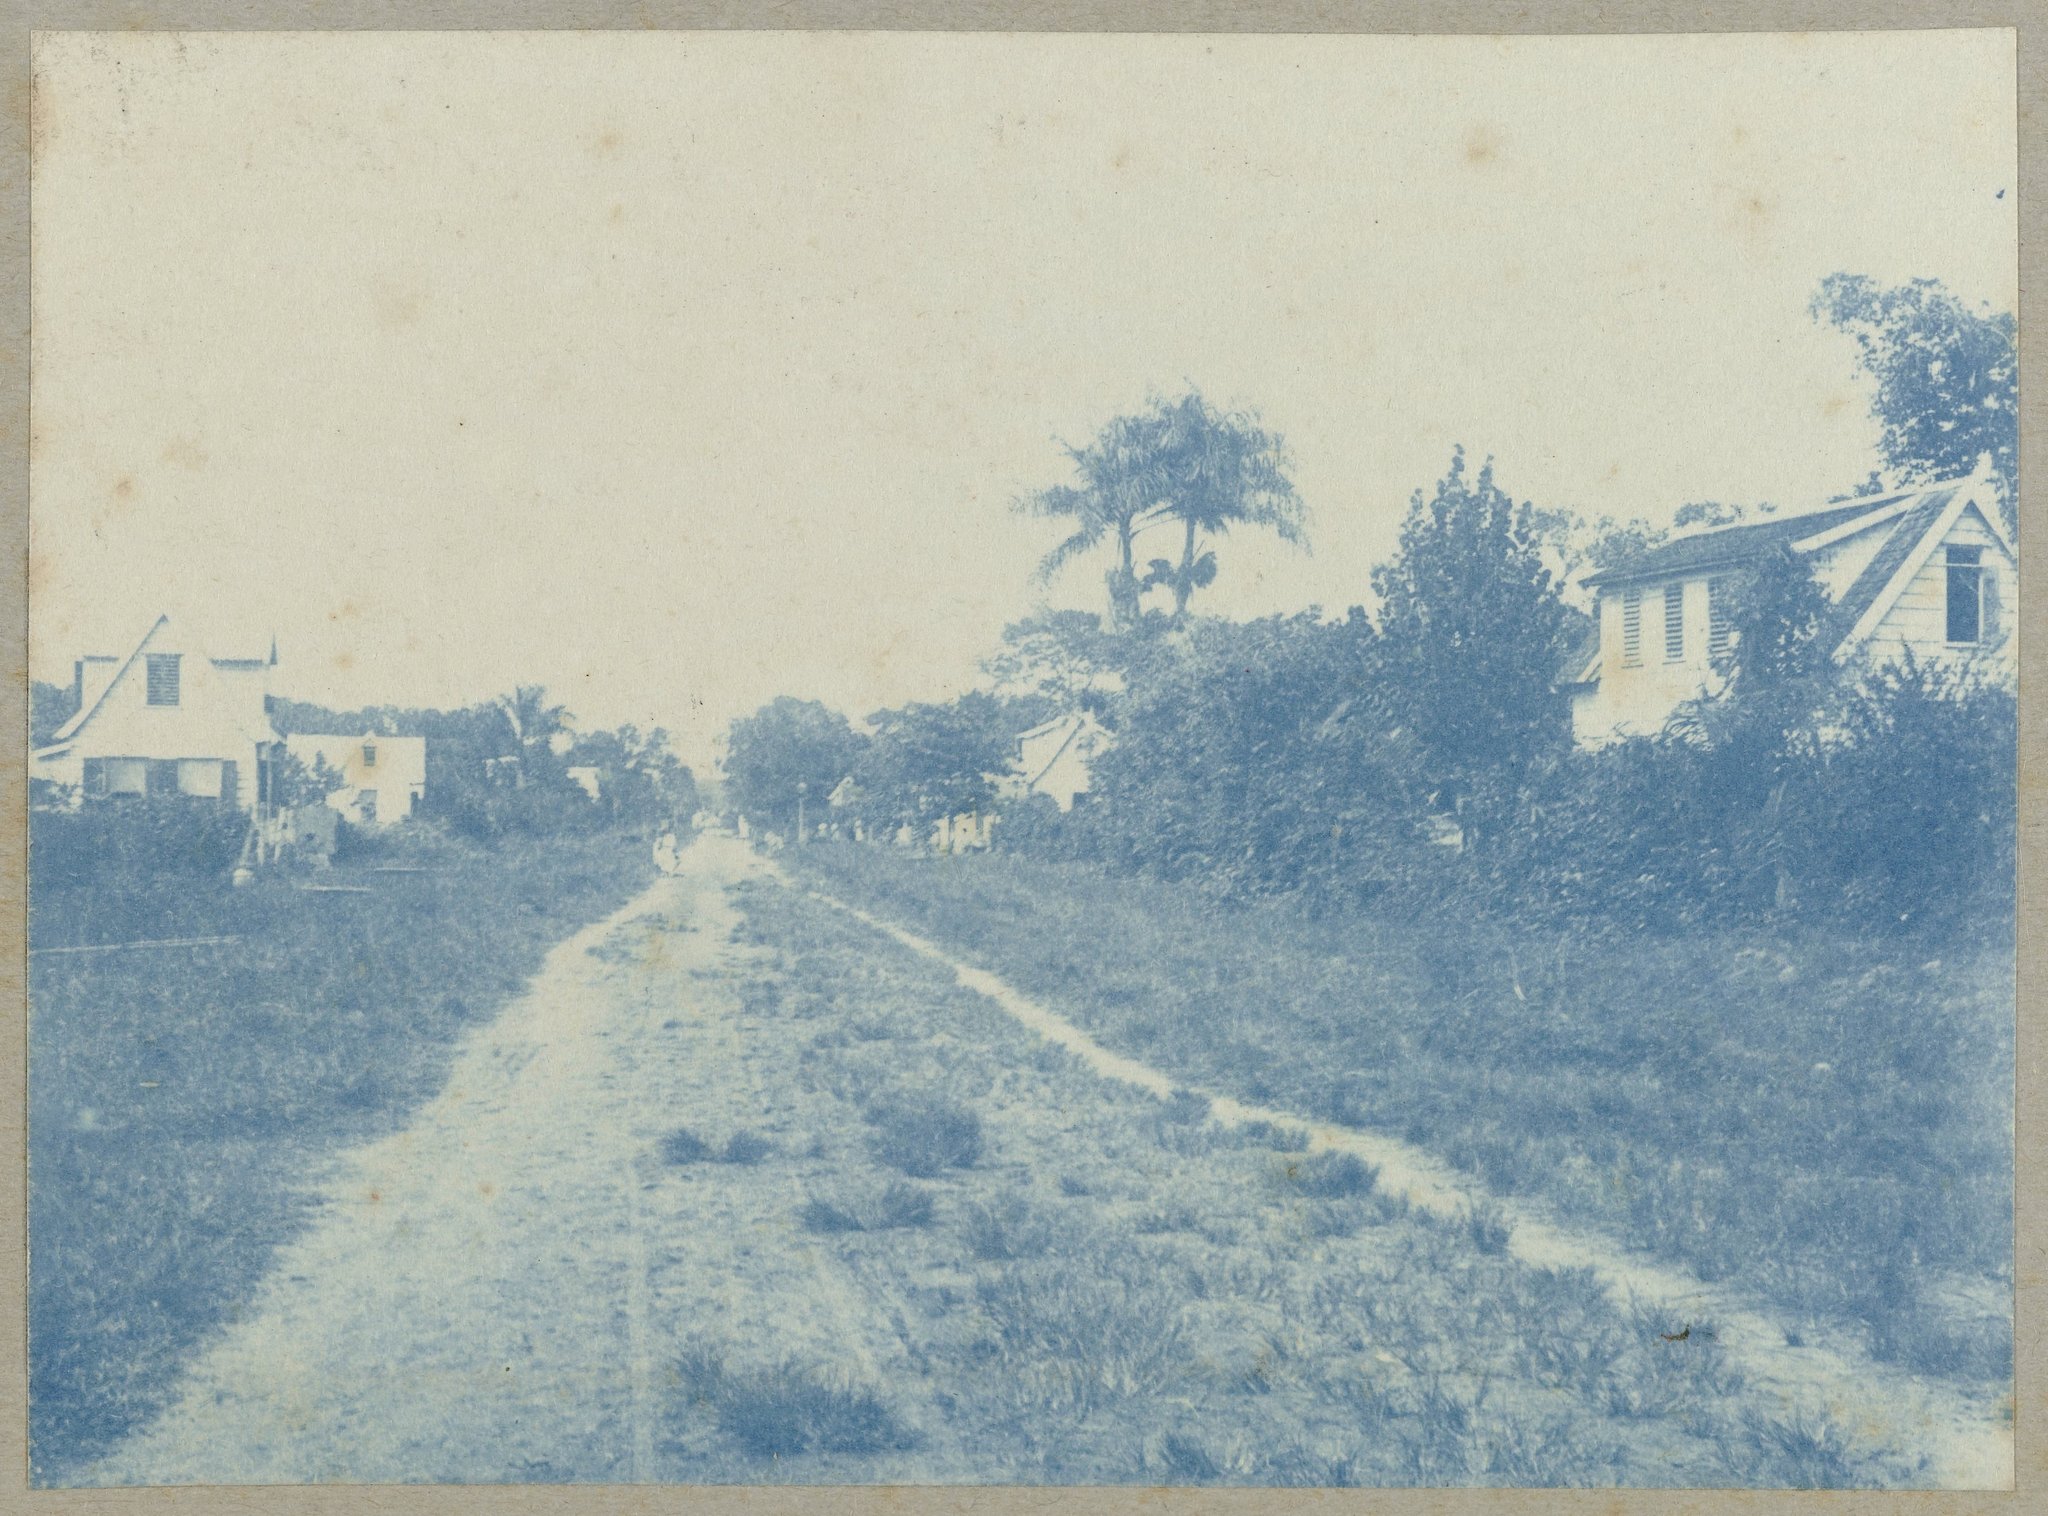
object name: photograph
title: Buitenwijk van Paramaribo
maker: hendrik doijer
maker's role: engineer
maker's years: 1863-1925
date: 1903-1910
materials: photographic support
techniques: cyanotype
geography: suriname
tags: suriname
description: Gezicht op een weg door een buitenwijk van Paramaribo. Onderdeel van het fotoalbum Souvenir de Voyage (deel 2), over het leven van de familie Doijer in en rond de plantage Ma Retraite in Suriname in de jaren 1903-1910.